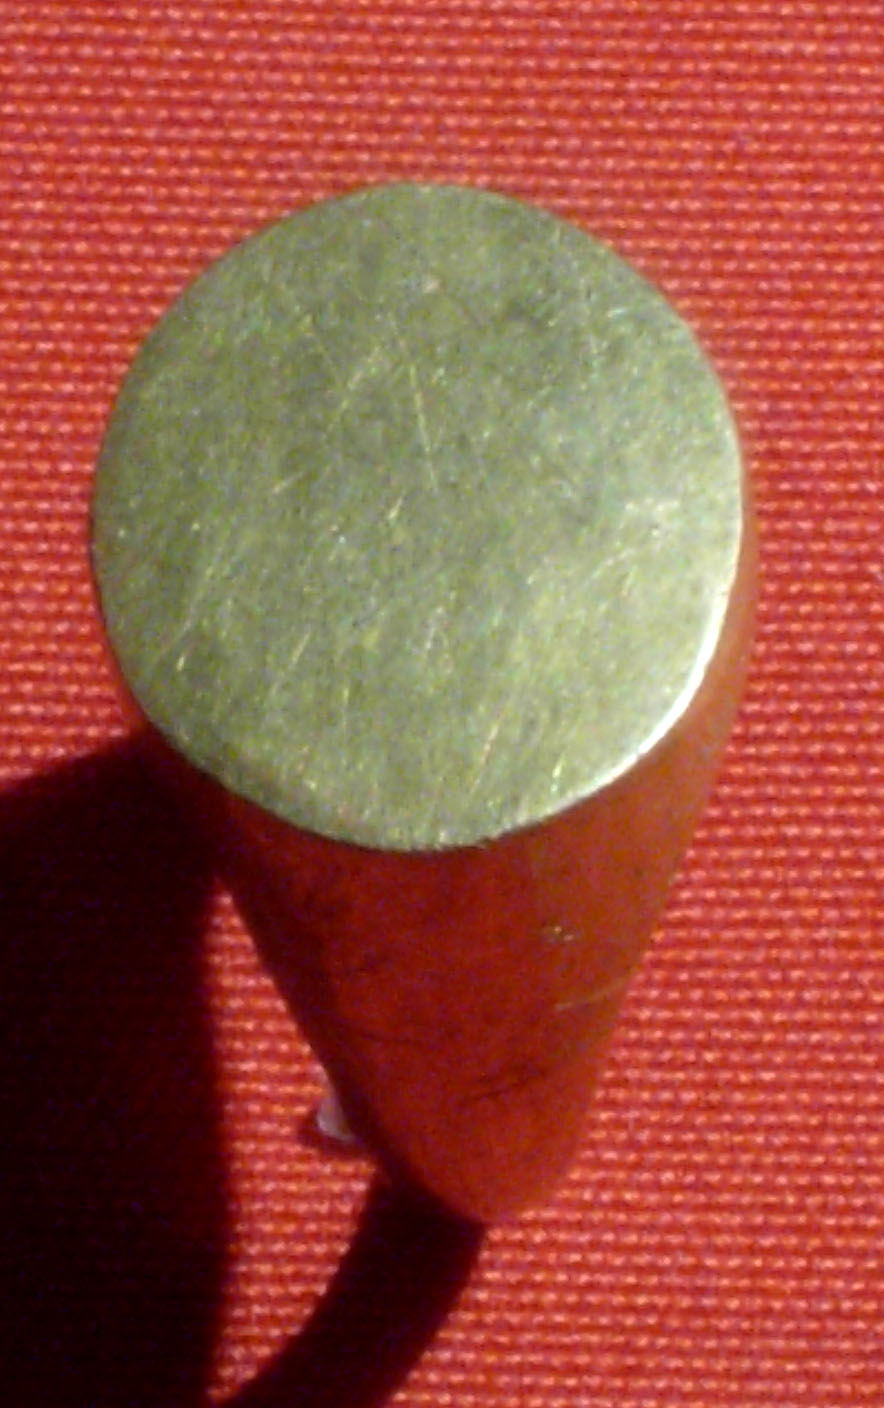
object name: ring, cast, plain bezel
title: Cast ring with plain bezel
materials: gold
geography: egypt